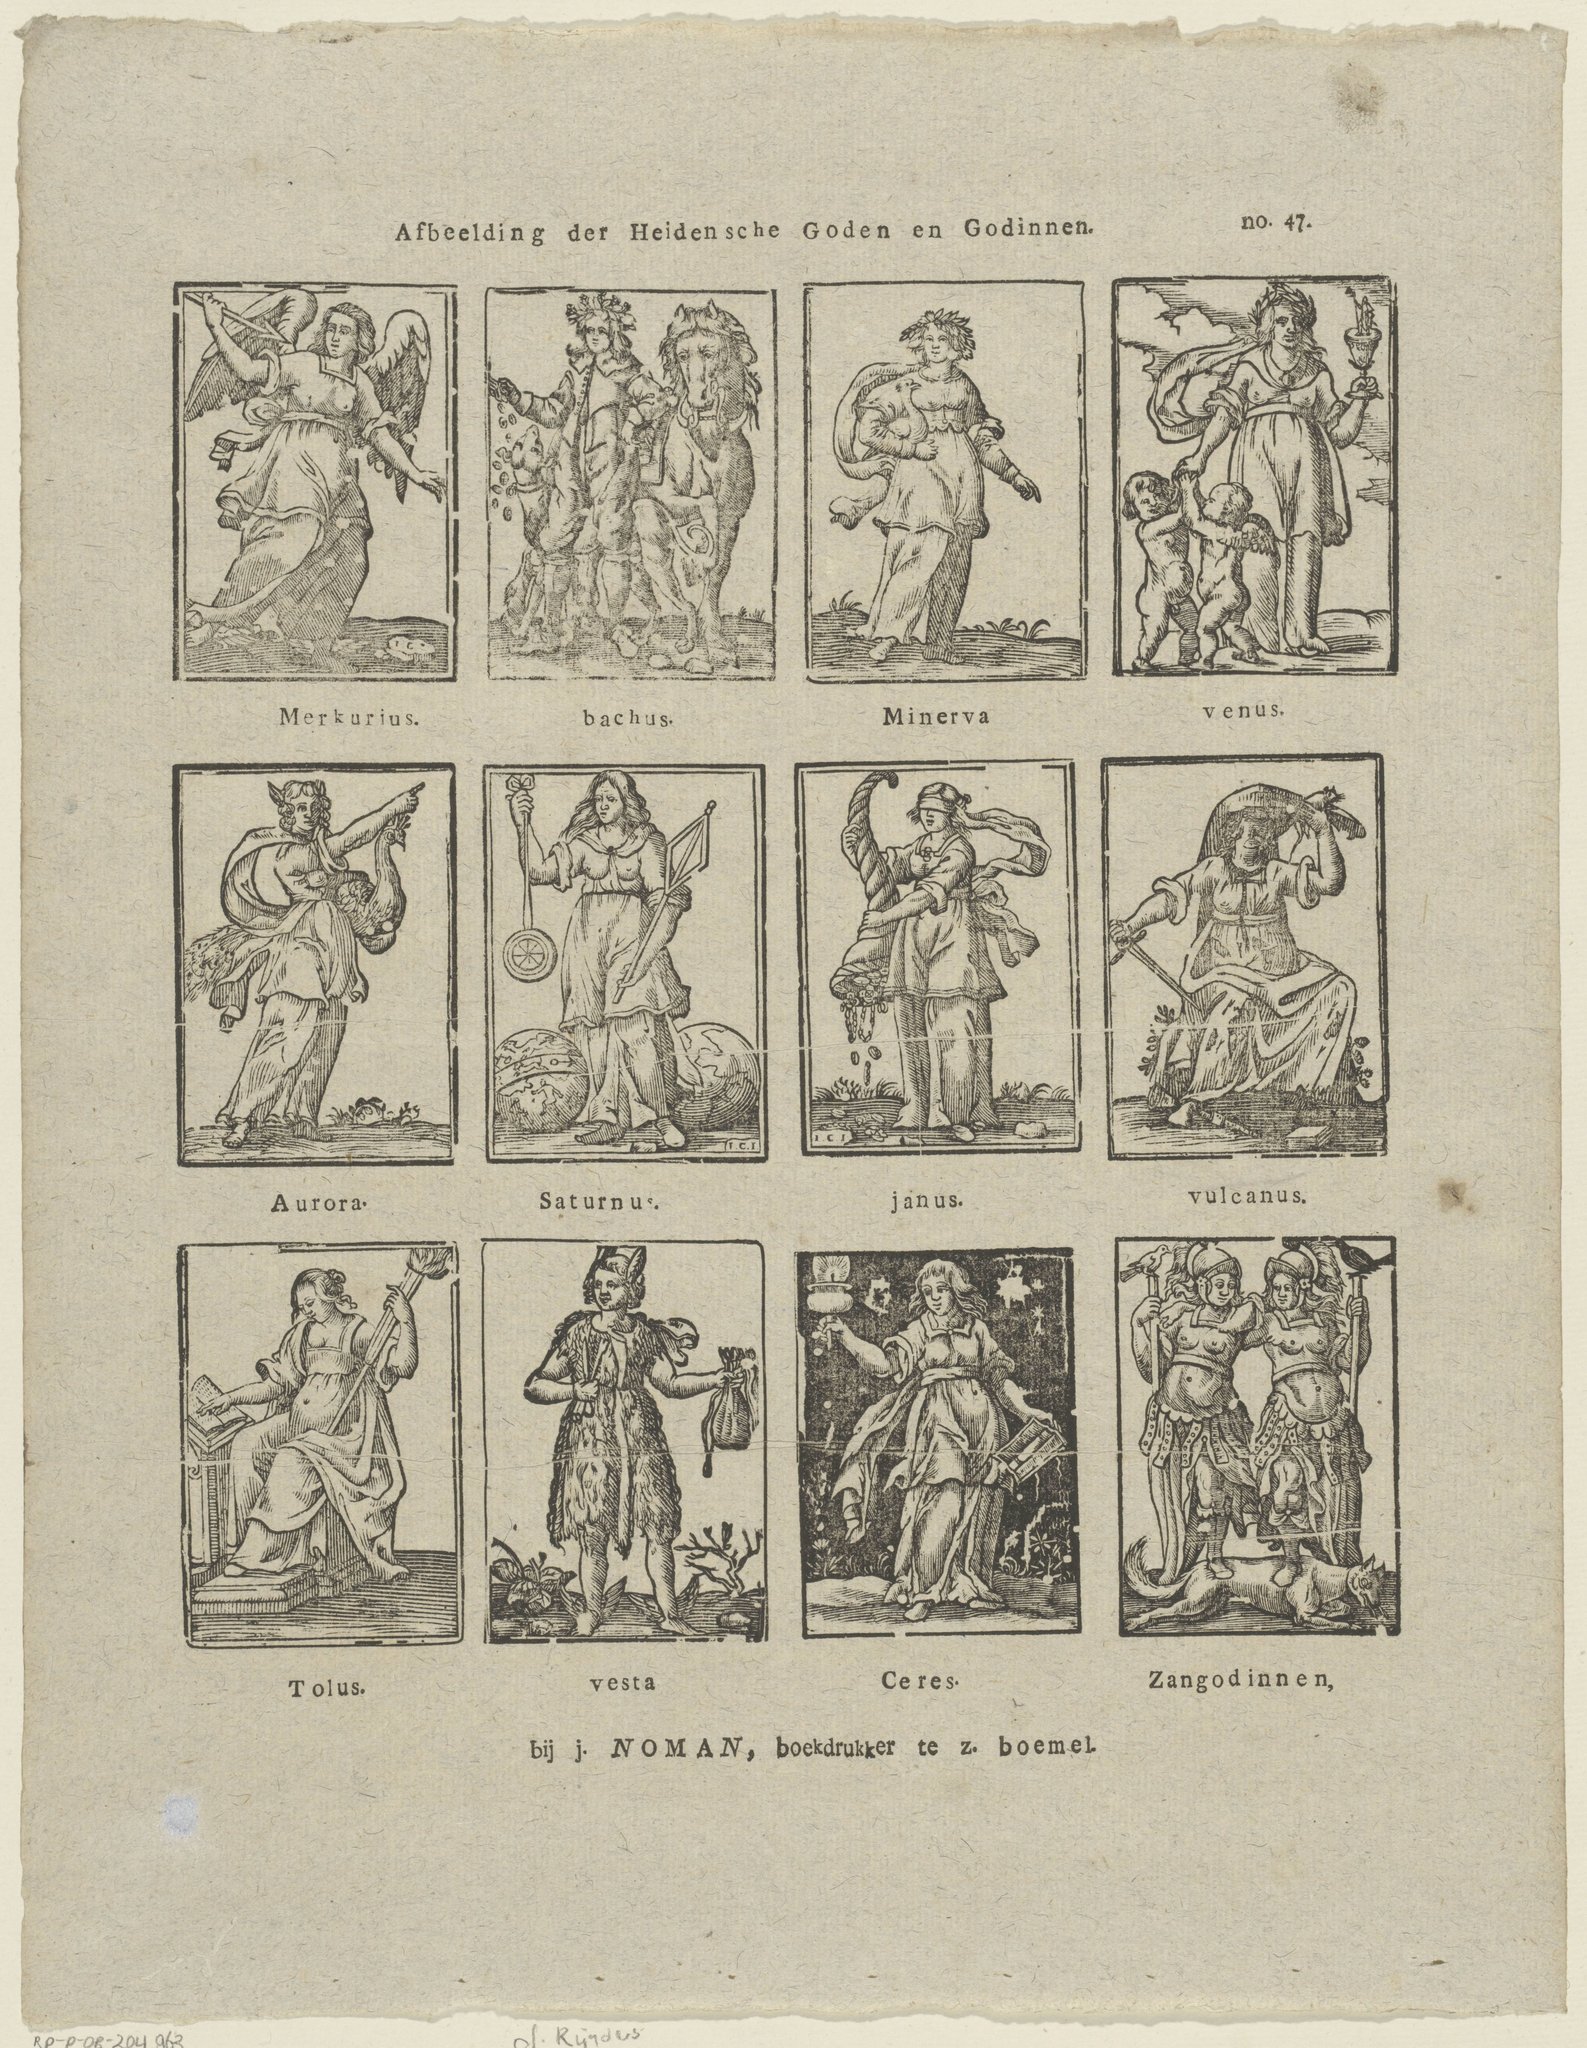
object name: print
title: Afbeelding der heidensche goden en godinnen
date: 1806-1830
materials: paper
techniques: letterpress printing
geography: zaltbommel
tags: (story of) bacchus (dionysus), liber, (story of) minerva (pallas, athena), (story of) mercury (hermes), (story of) venus (aphrodite), gods ~ classical mythology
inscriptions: collector's mark: Lugt 2760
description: Blad met 12 voorstellingen van mythologische figuren, onder wie Mercurius, Bacchus, Minerva en Venus. Onder elke afbeelding een onderschrift. Genummerd rechtsboven: no. 47.